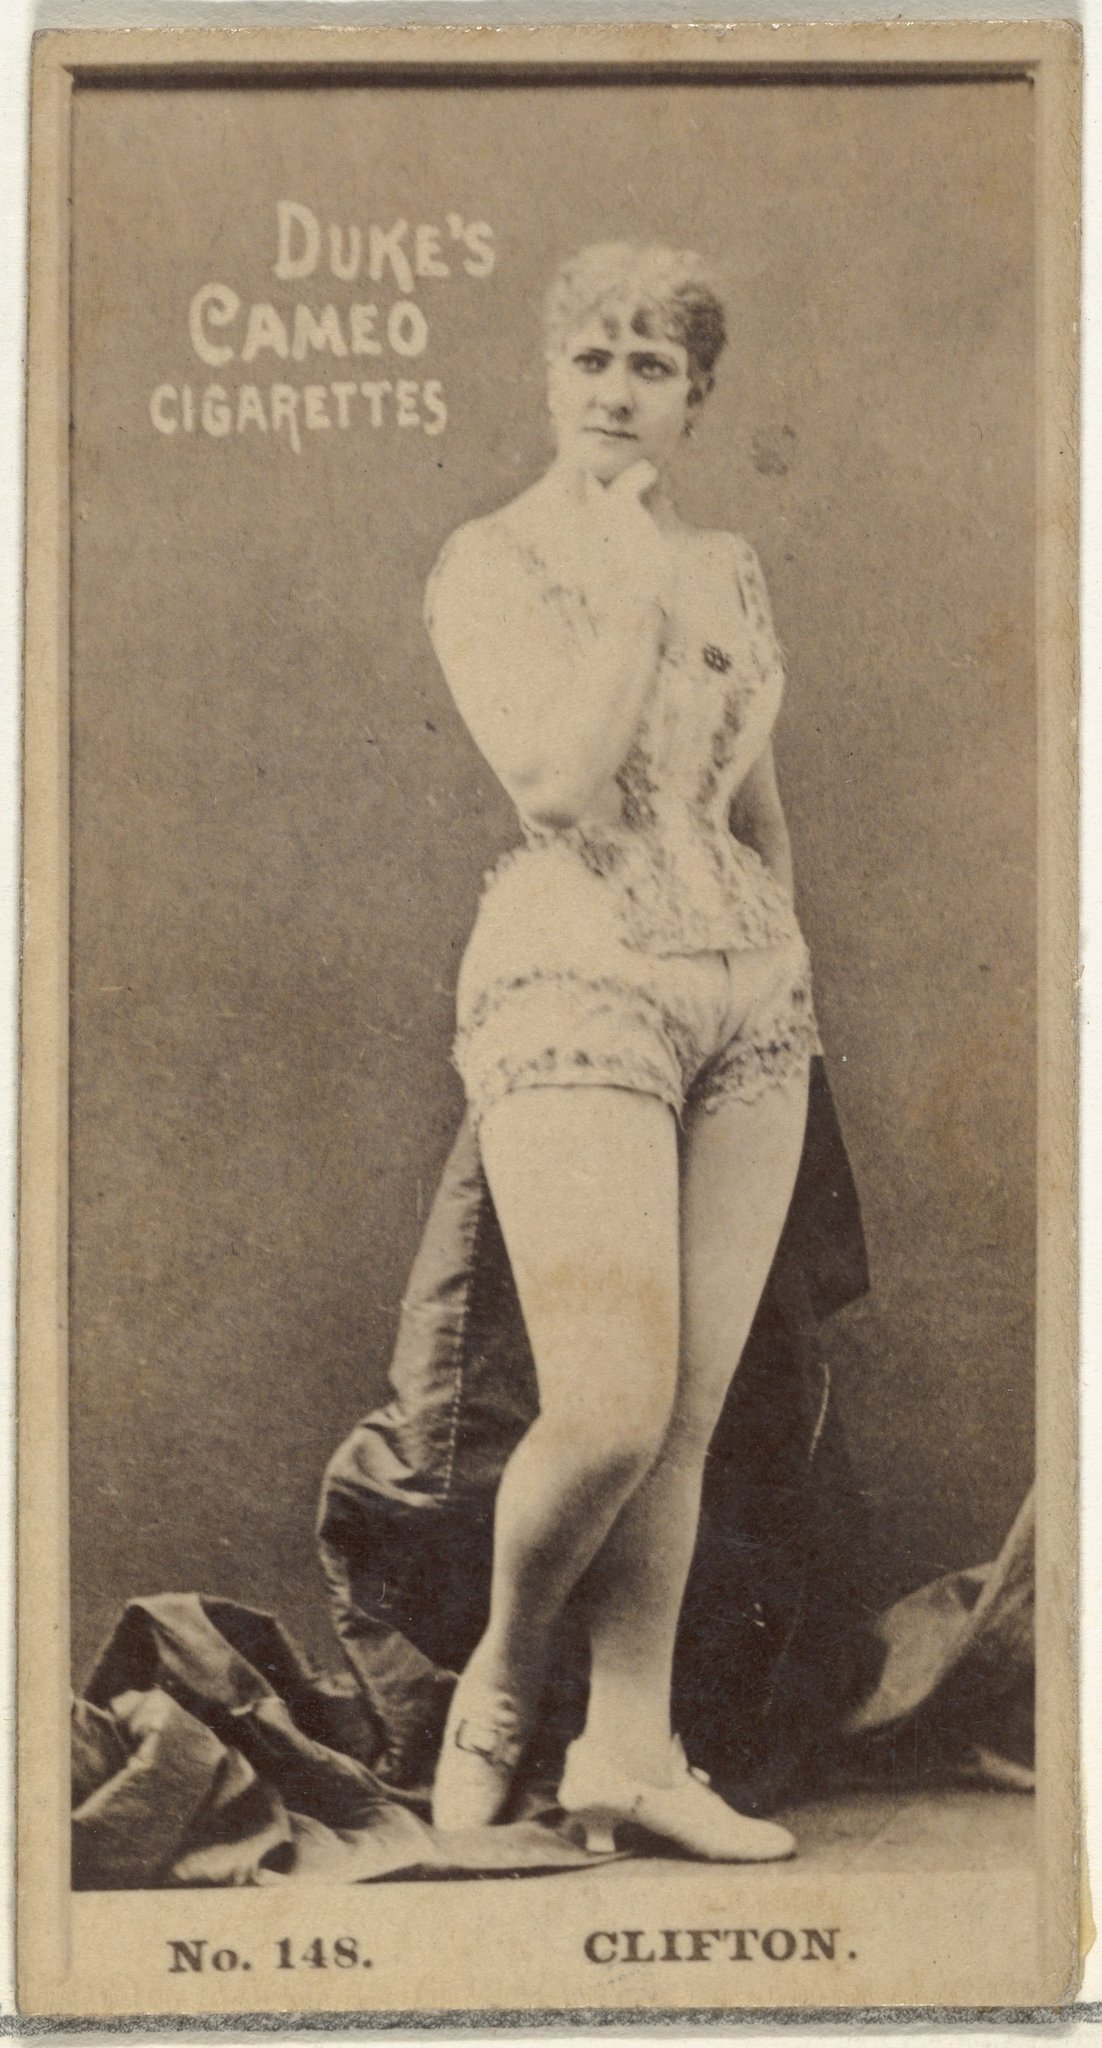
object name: photograph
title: Card Number 148, Clifton, from the Actors and Actresses series (N145-4) issued by Duke Sons & Co. to promote Cameo Cigarettes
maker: w. duke, sons & co.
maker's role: publisher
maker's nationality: american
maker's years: 1870-1920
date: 1880-1889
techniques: albumen silver print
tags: portraits,women,actresses